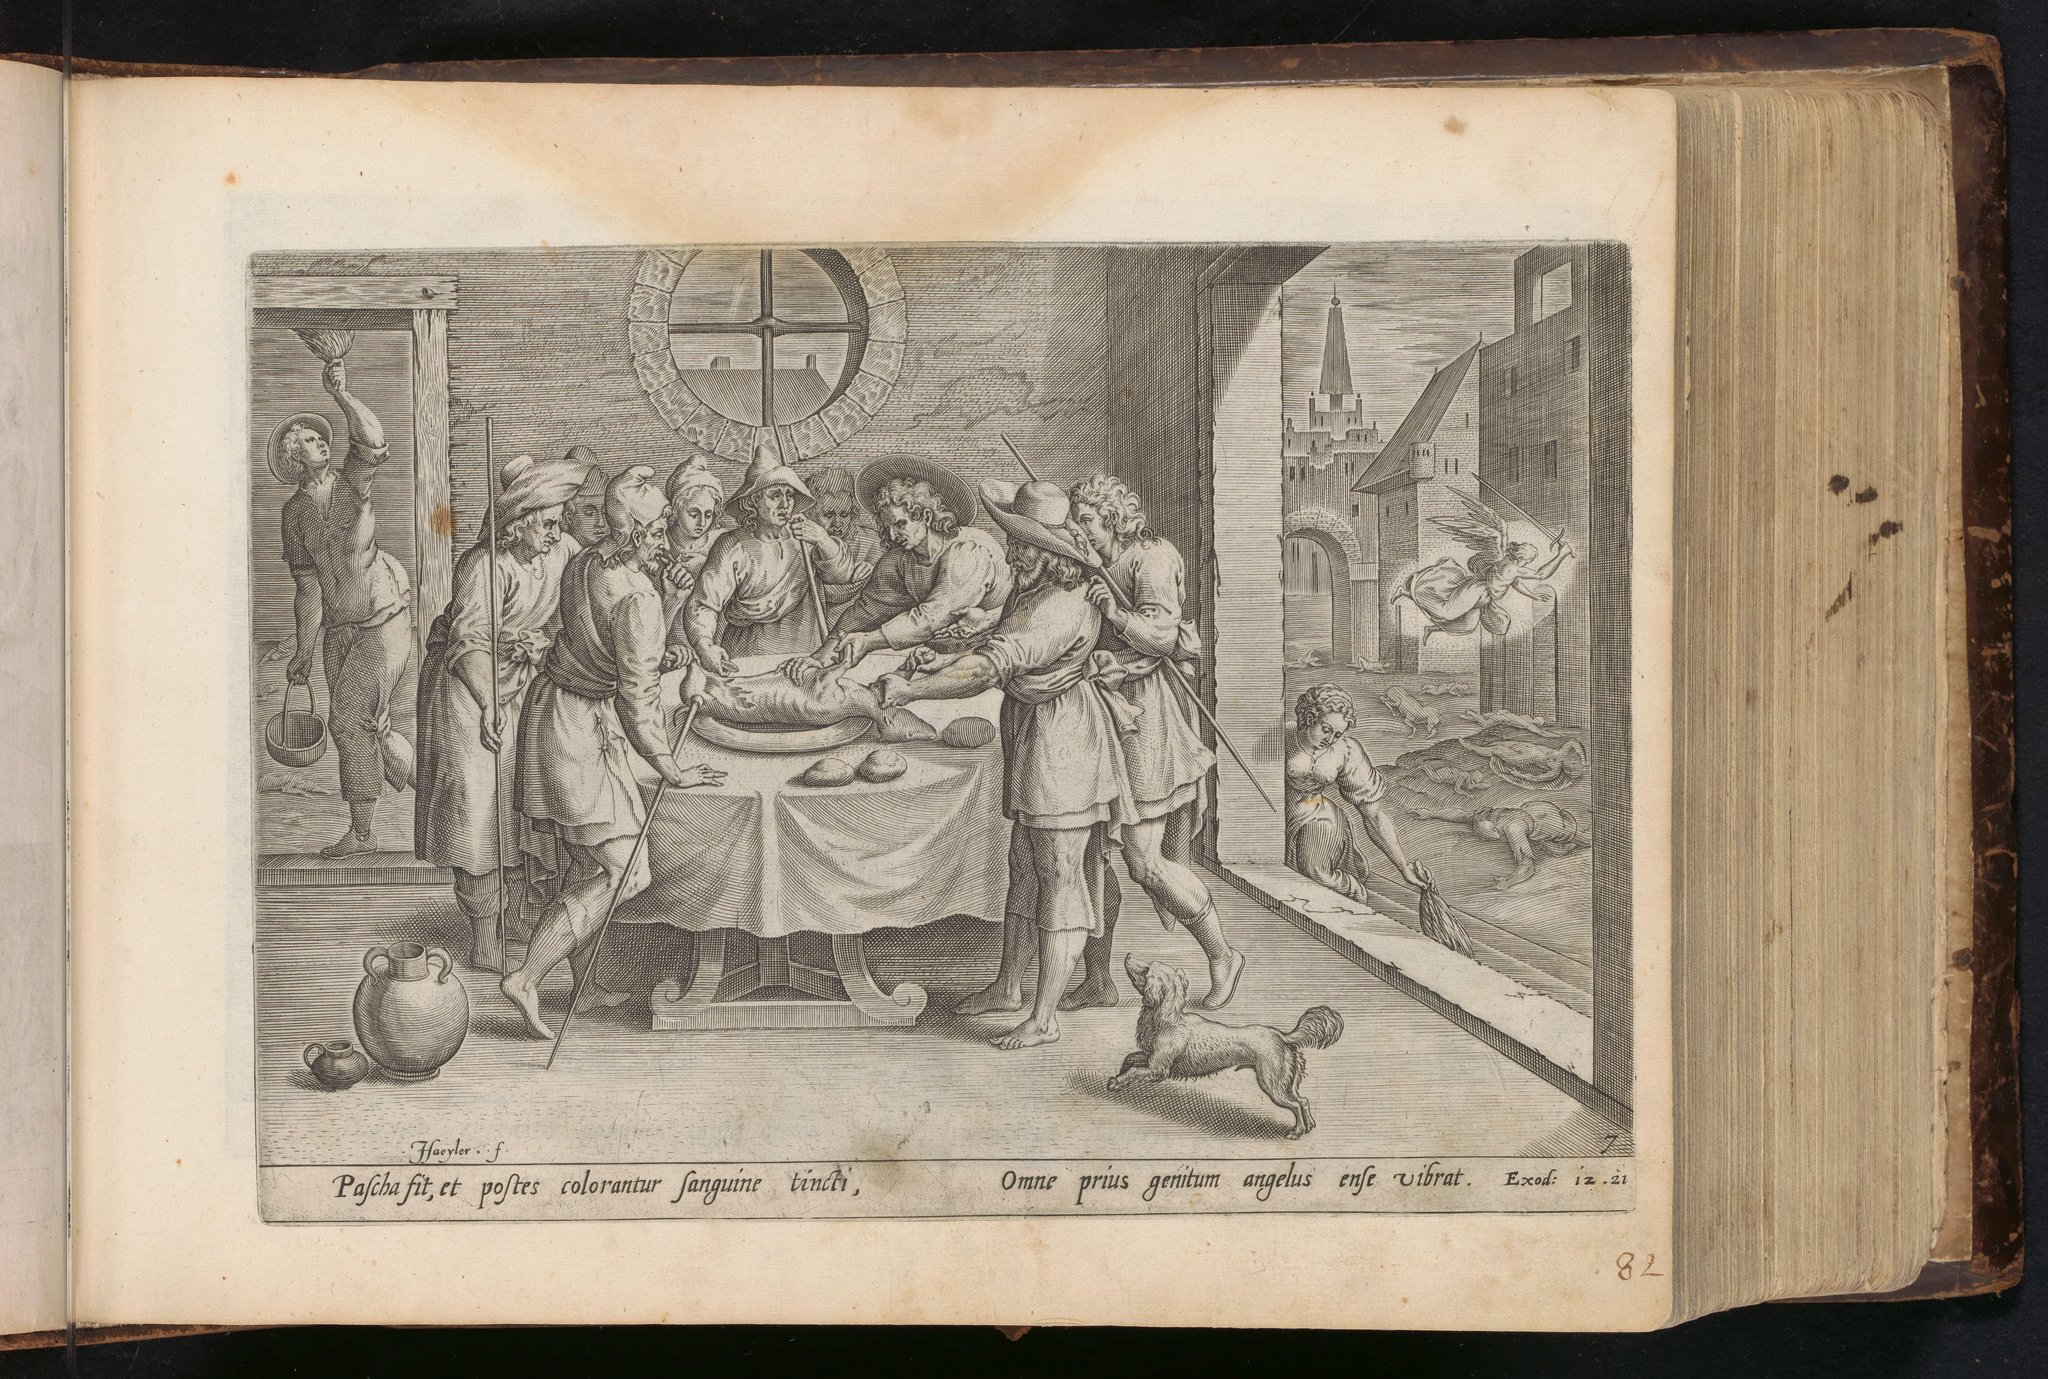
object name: print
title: Pesachfeest en de tiende plaag van Egypte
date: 1579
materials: paper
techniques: engraving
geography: amsterdam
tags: with lamb's blood the israelites make marks (usually tau-crosses) on the doorposts of their houses, the israelites eat the passover lamb standing about a table with their loins girt, their shoes on their feet and with staves in their hands, ready to depart, the plague of the first-born: the destroying angel passes through the land and kills every egyptian first-born of man and animal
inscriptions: number: ‘82’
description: Op de voorgrond een Joodse familie rond een tafel met het pesachoffer: een geslacht lam. De deuren van Joodse huizen worden met lamsbloed gemarkeerd. Rechts de tiende plaag van Egypte: een doodsengel doodt alle eerstgeborenen van Egypte, maar gaat voorbij aan de huizen met bloed aan de deurposten. Onder de voorstelling een verwijzing in het Latijn naar de Bijbeltekst in Ex. 12:21. Deze prent maakt deel uit van een album.